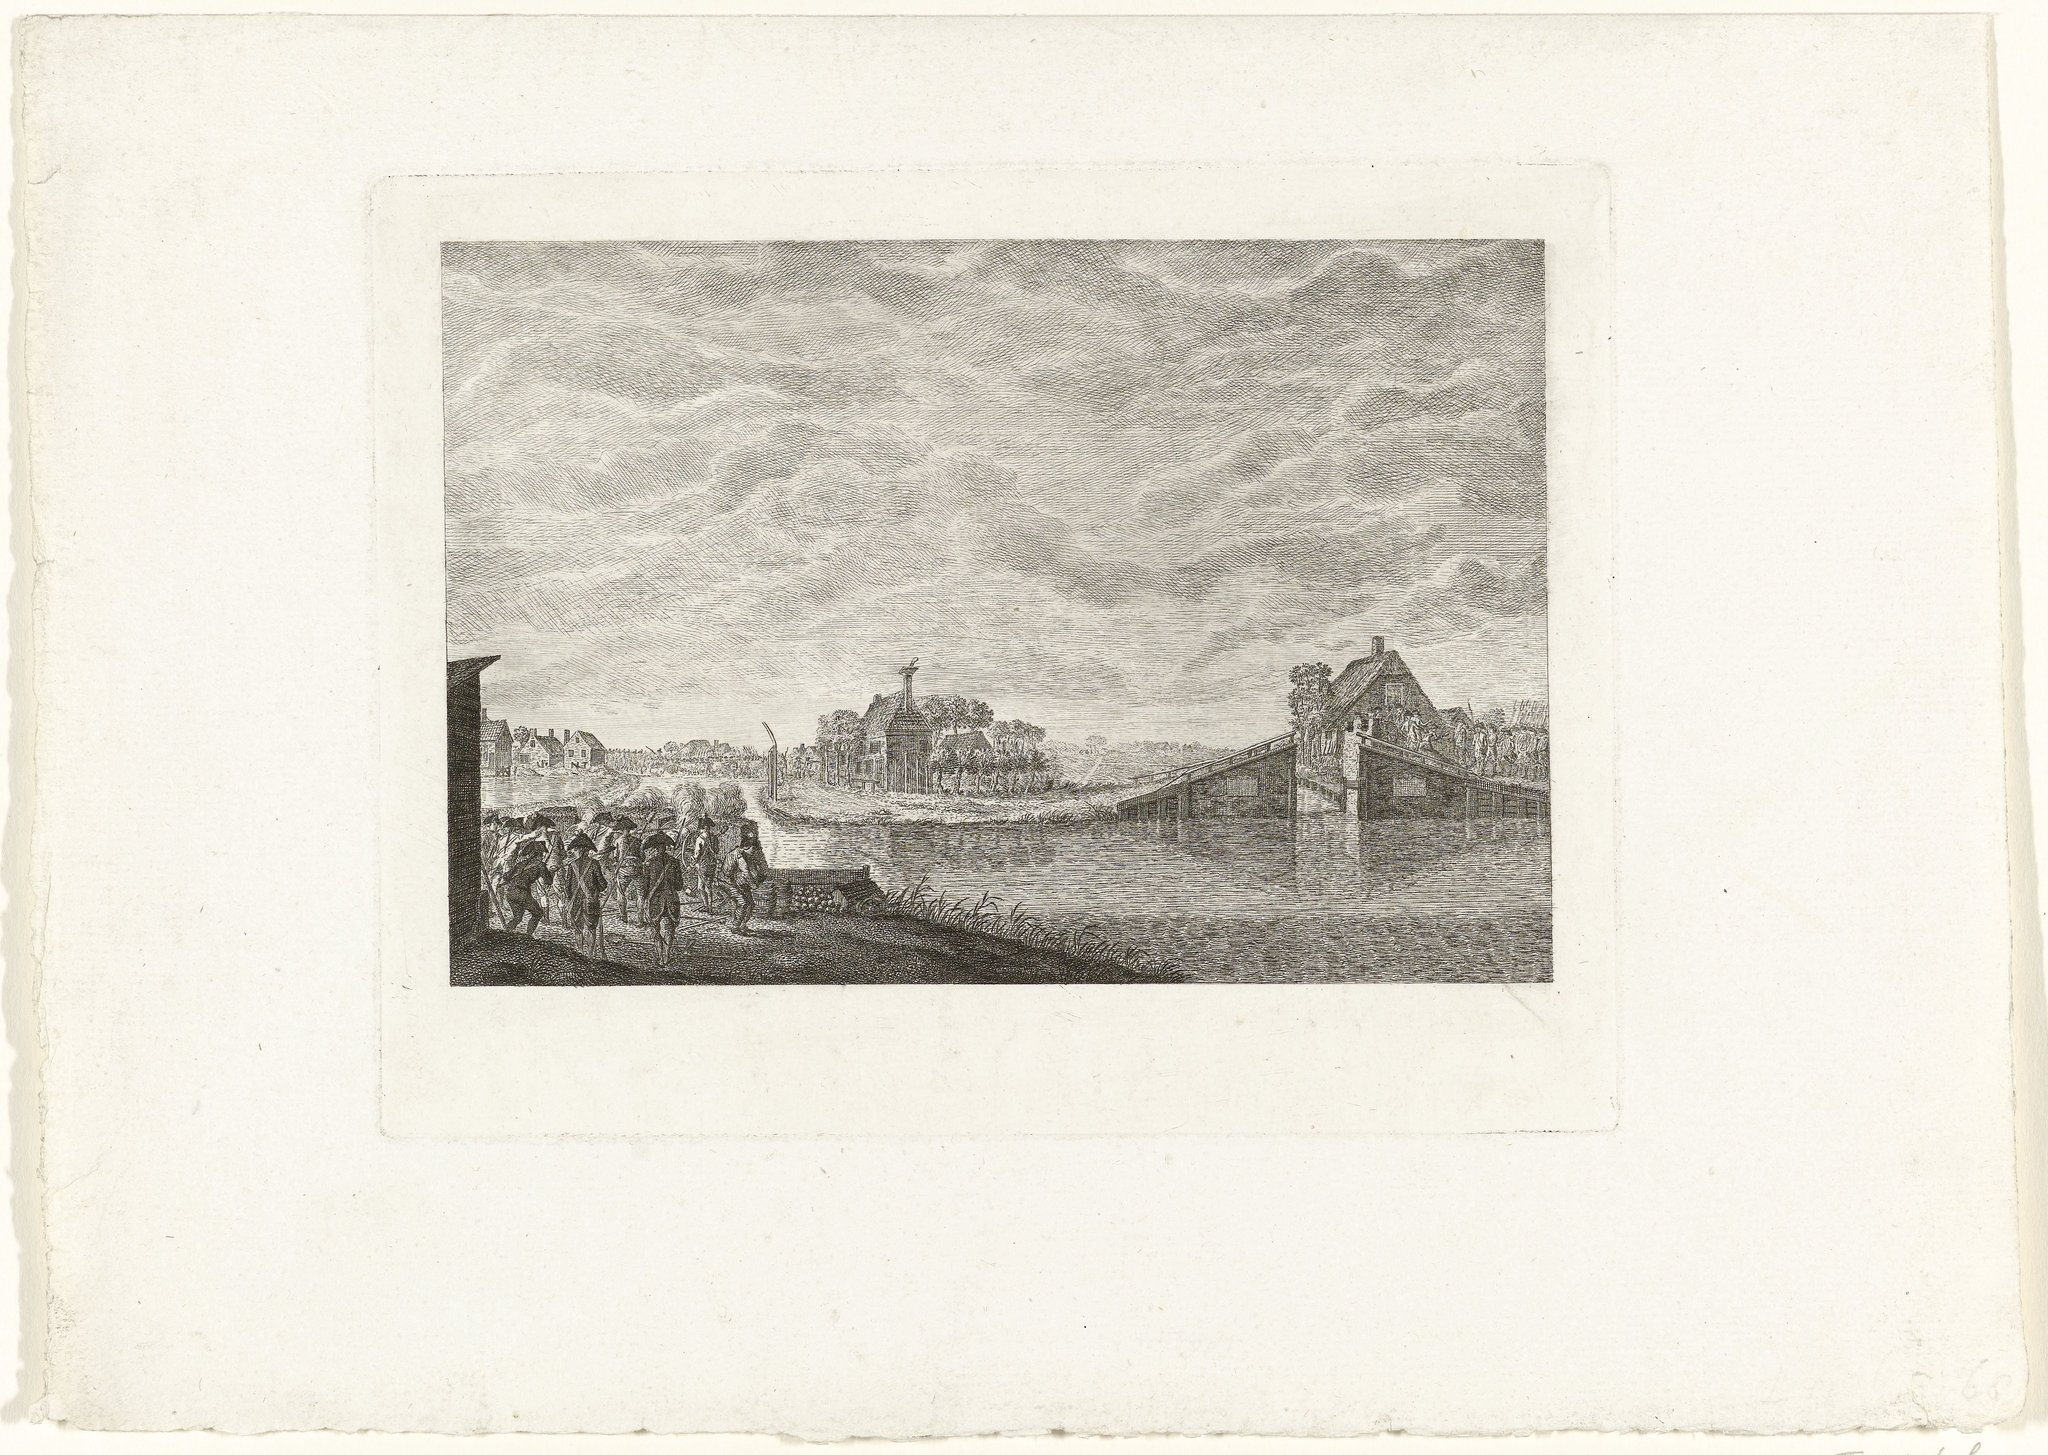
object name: print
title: Aanval bij Ouderkerk aan de Amstel op de afgebroken brug, 1787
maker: Anonymous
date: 1789-1794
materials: paper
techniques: engraving, etching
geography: northern netherlands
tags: (military) attack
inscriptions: collector's mark: Lugt 2228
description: Aanval bij de afgebroken brug bij het grote loopveld in Ouderkerk aan de Amstel door de Pruisische troepen onder commando van generaal Friedrich Adolf von Kalckreuth, verdedigd door Amsterdamse schutters onder commando van kolonel George Hendrik de Wilde, 1 oktober 1787.